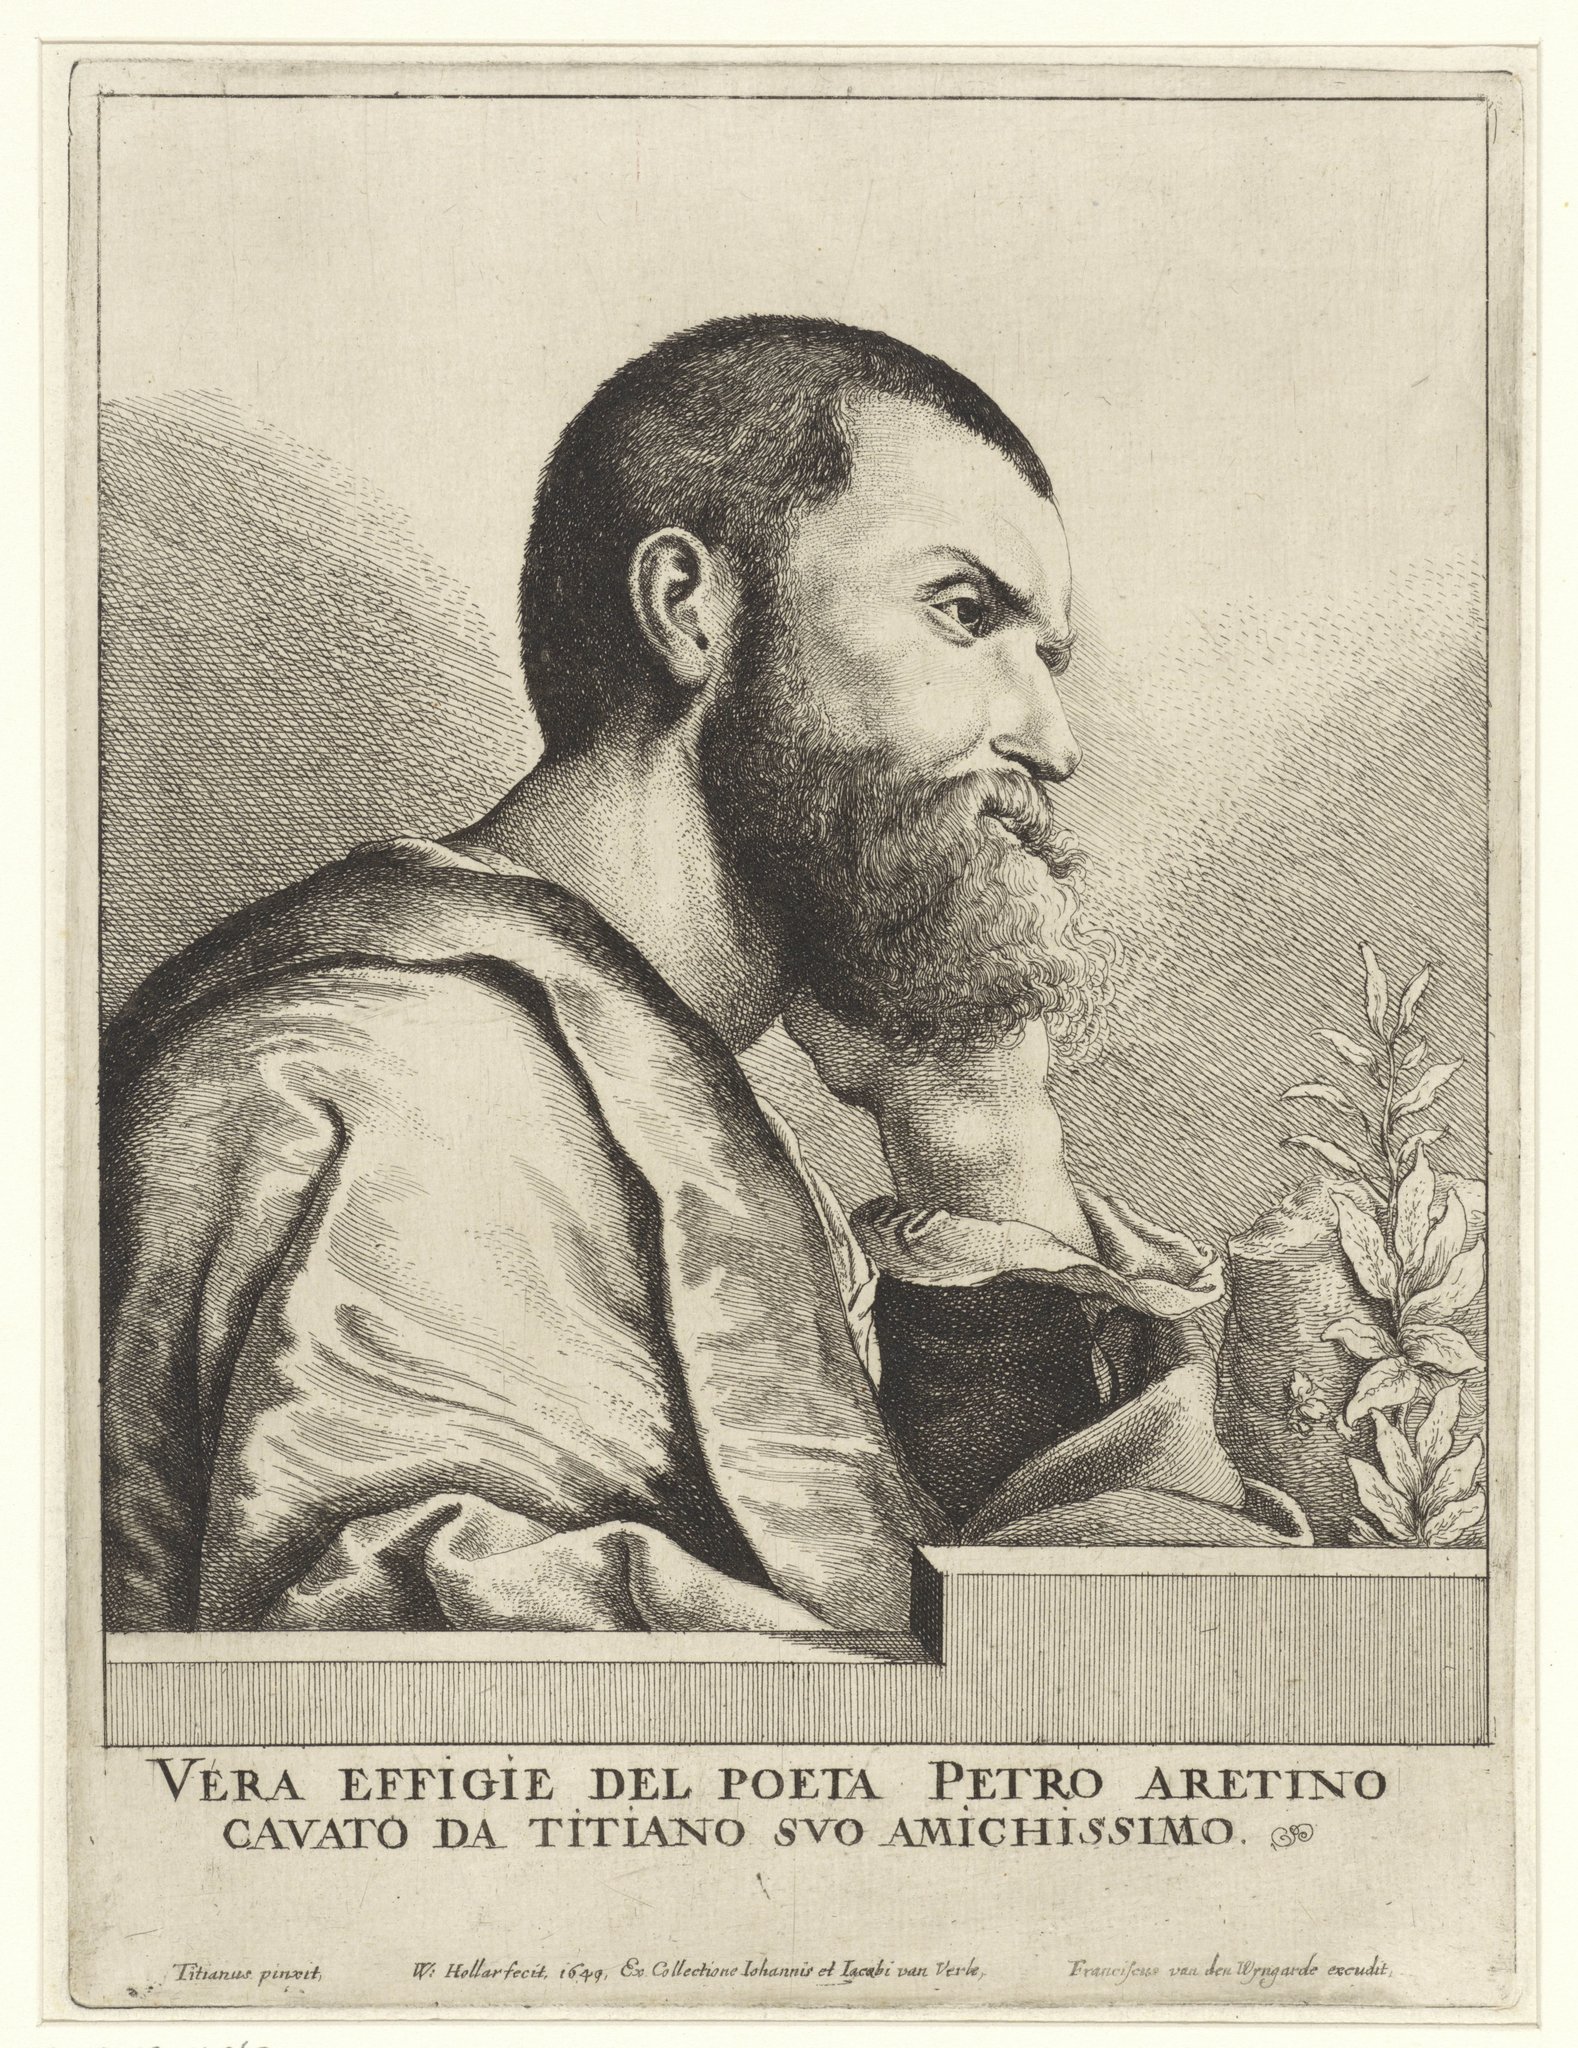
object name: print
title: Portret van Pietro Aretino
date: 1649-1651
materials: paper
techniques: etching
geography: antwerp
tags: venice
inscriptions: collector's mark: Lugt 240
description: De prent maakt deel uit van een tiendelige serie met Italiaanse portretten (ongenummerd).